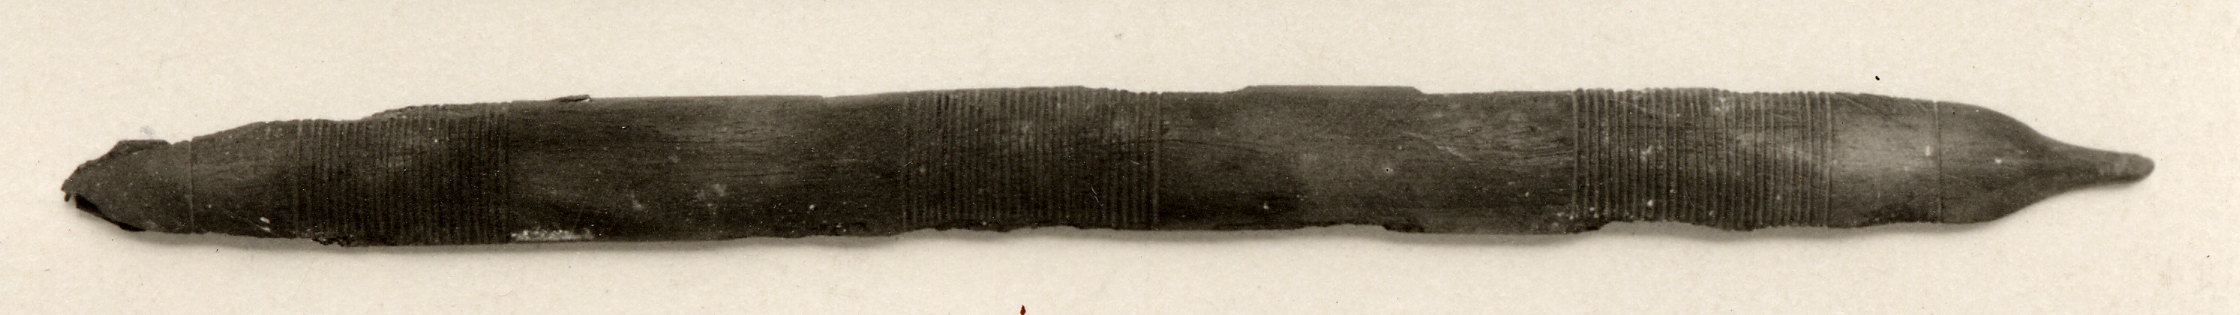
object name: throw stick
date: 1635-1458 BCE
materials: wood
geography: egypt